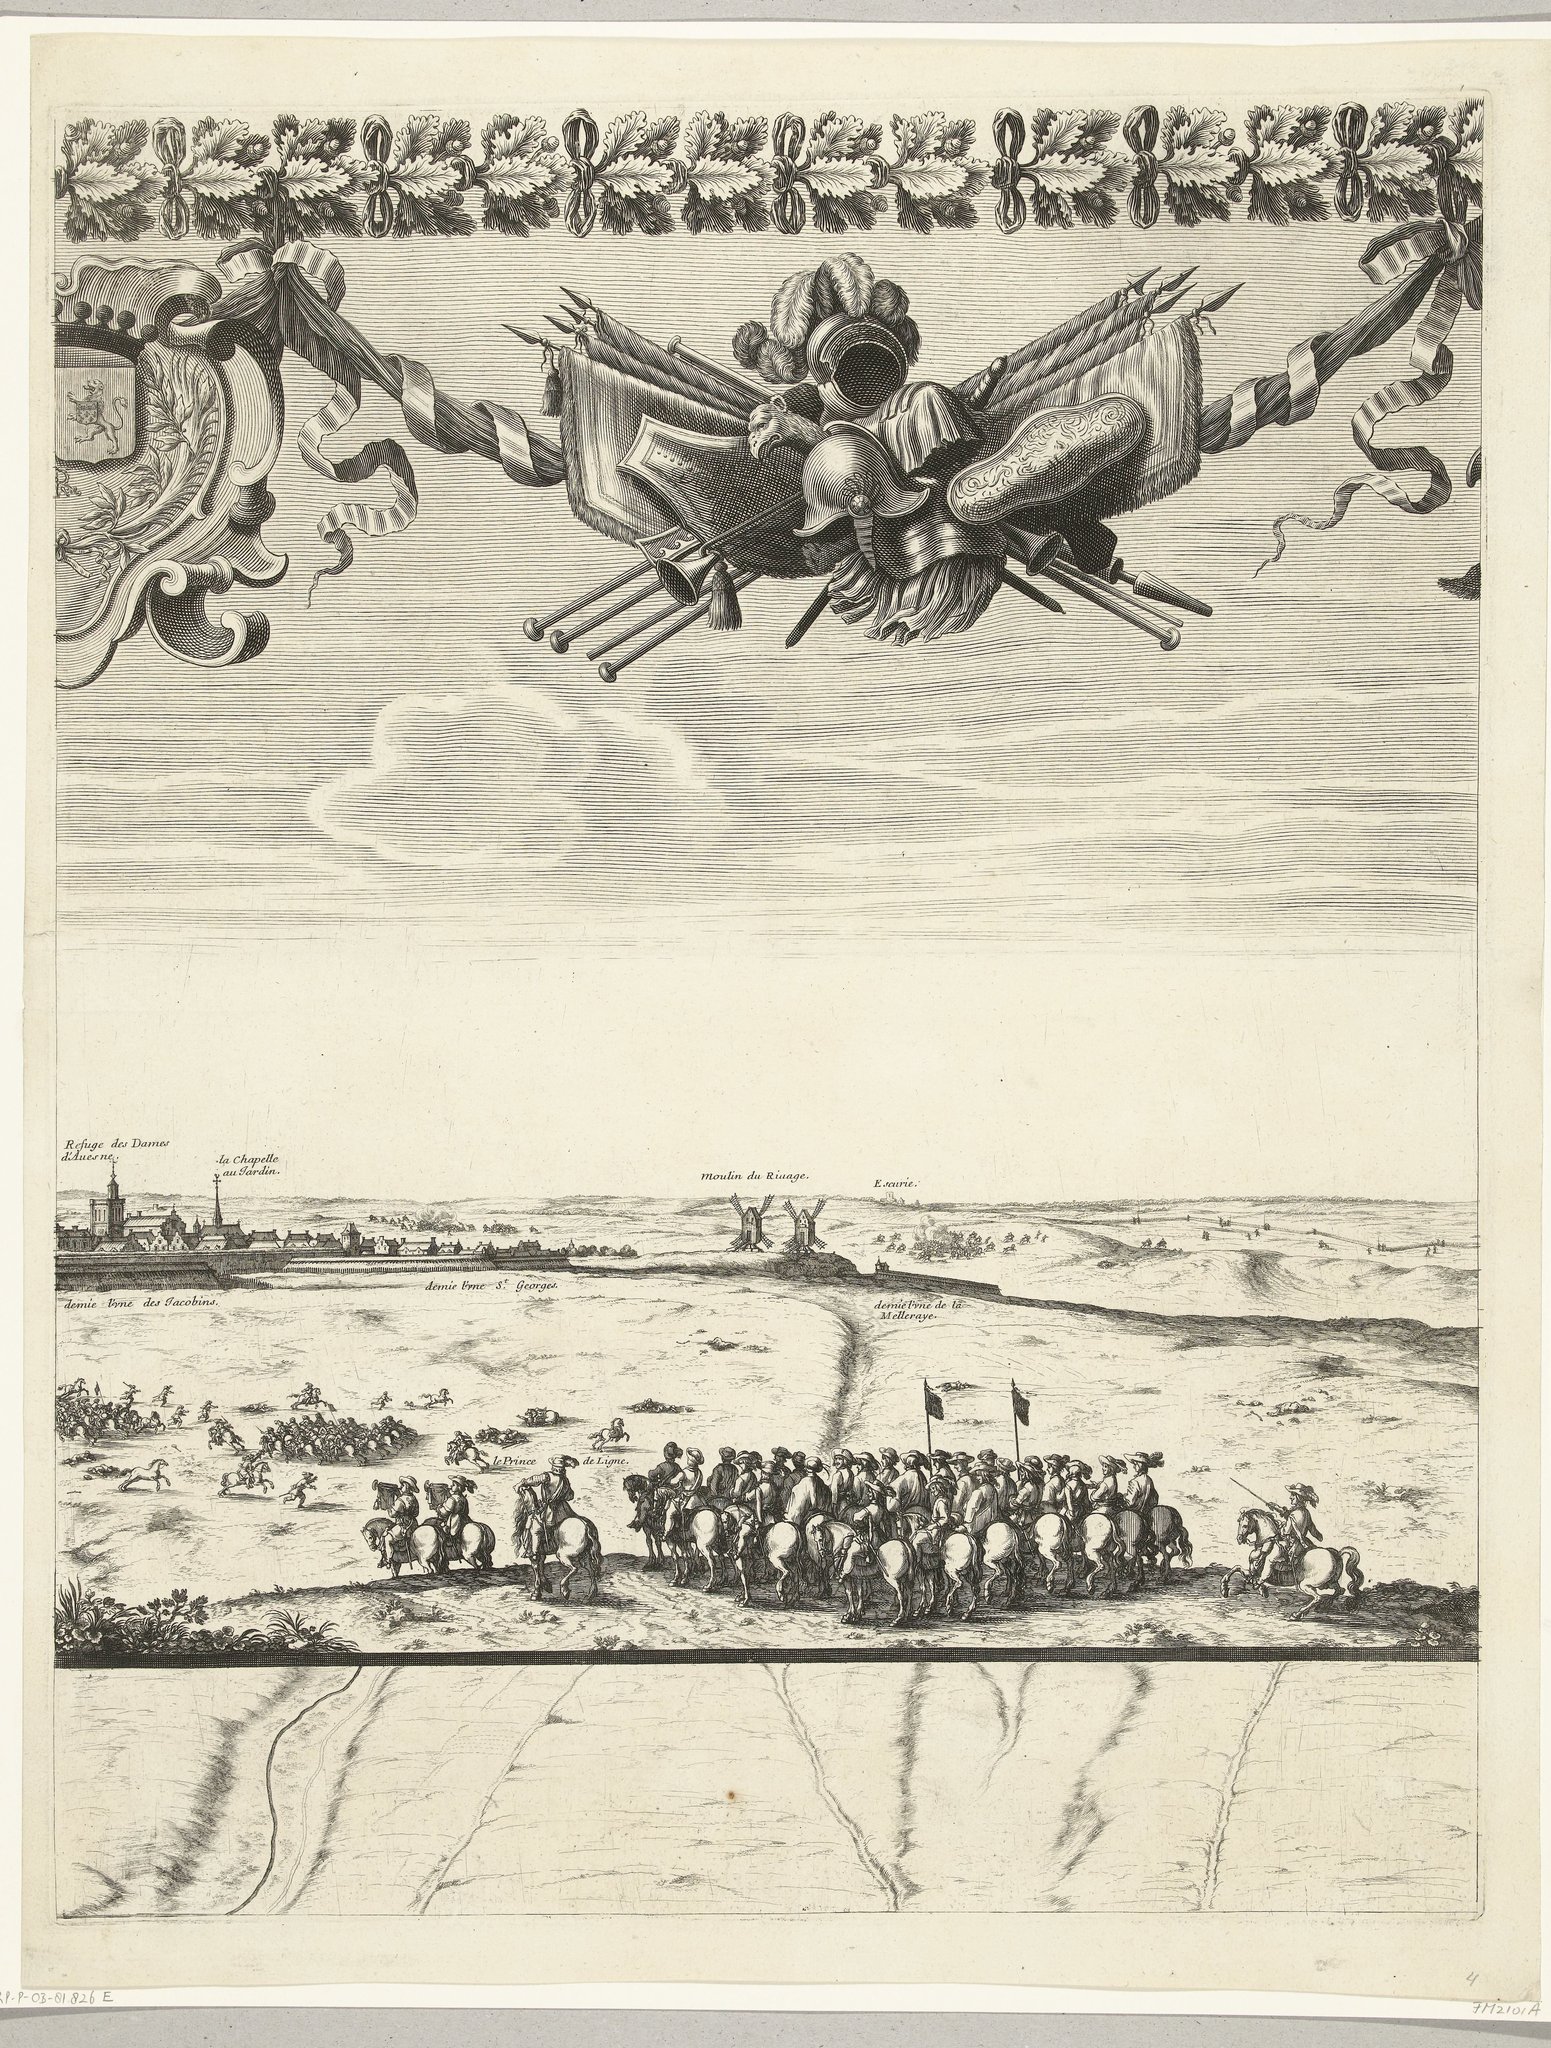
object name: print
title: Ontzet van Arras, belegerd door de Spanjaarden (bovenste rij, plaat 4), 1654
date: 1655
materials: paper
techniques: engraving, etching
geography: france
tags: vienna, leopold willem van oostenrijk (landvoogd der zuidelijke nederlanden), raising the siege with outside assistance, relief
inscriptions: date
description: Ontzet van de stad Arras (Atrecht), belegerd door de Spanjaarden, 23-25 augustus 1654. Arras ontzet door het Franse leger onder de maarschalk Turenne van het beleg door de Spanjaarden onder Louis de Condé en aartshertog Leopold Willem. Vierde blad in de bovenste rij. Boven een wapentrofee, onder een deel van het profiel van de stad en de kaart van het beleg. Onderdeel van een ongemonteerd geheel bestaande uit een titelblad en een grote voorstelling op vijftien platen (de halve plaat rechtsonder ontbreekt).